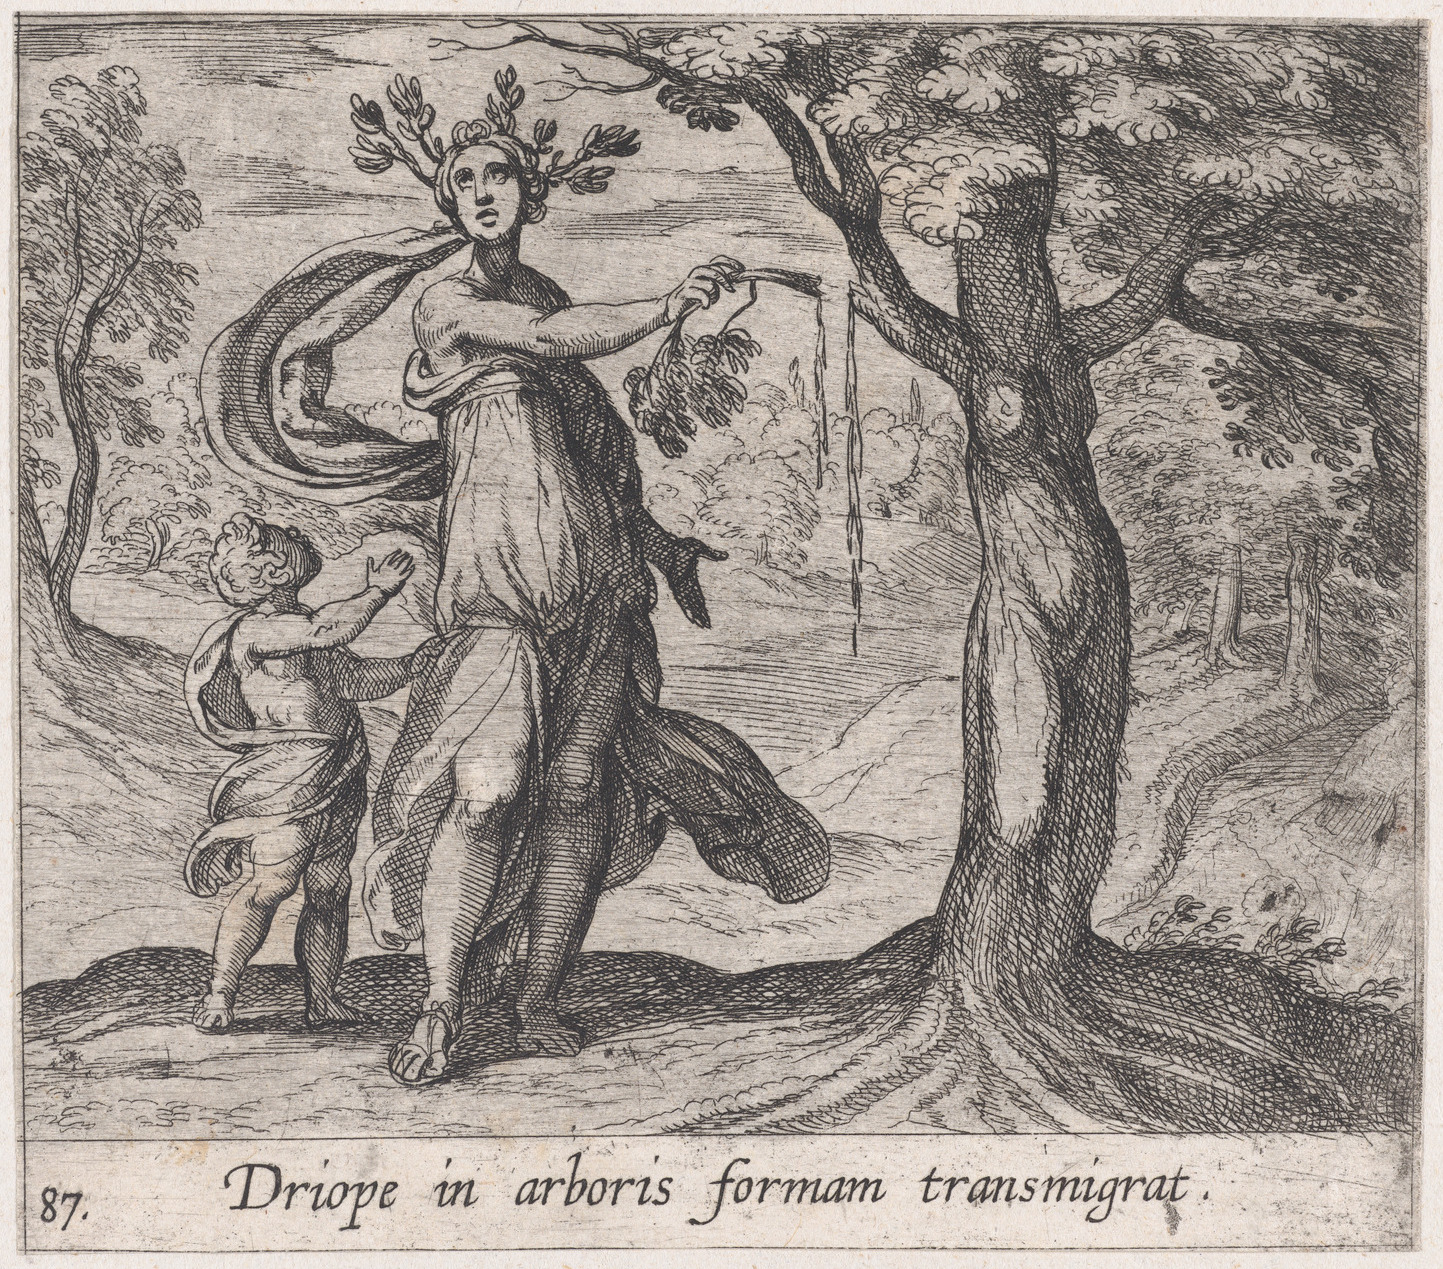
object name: print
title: Plate 87: Dryope Changed into a Lotus Tree (Driope in arboris formam transmigrat), from Ovid's 'Metamorphoses'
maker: antonio tempesta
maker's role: artist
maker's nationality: italian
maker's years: 1555-1630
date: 1606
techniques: etching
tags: children,women,trees